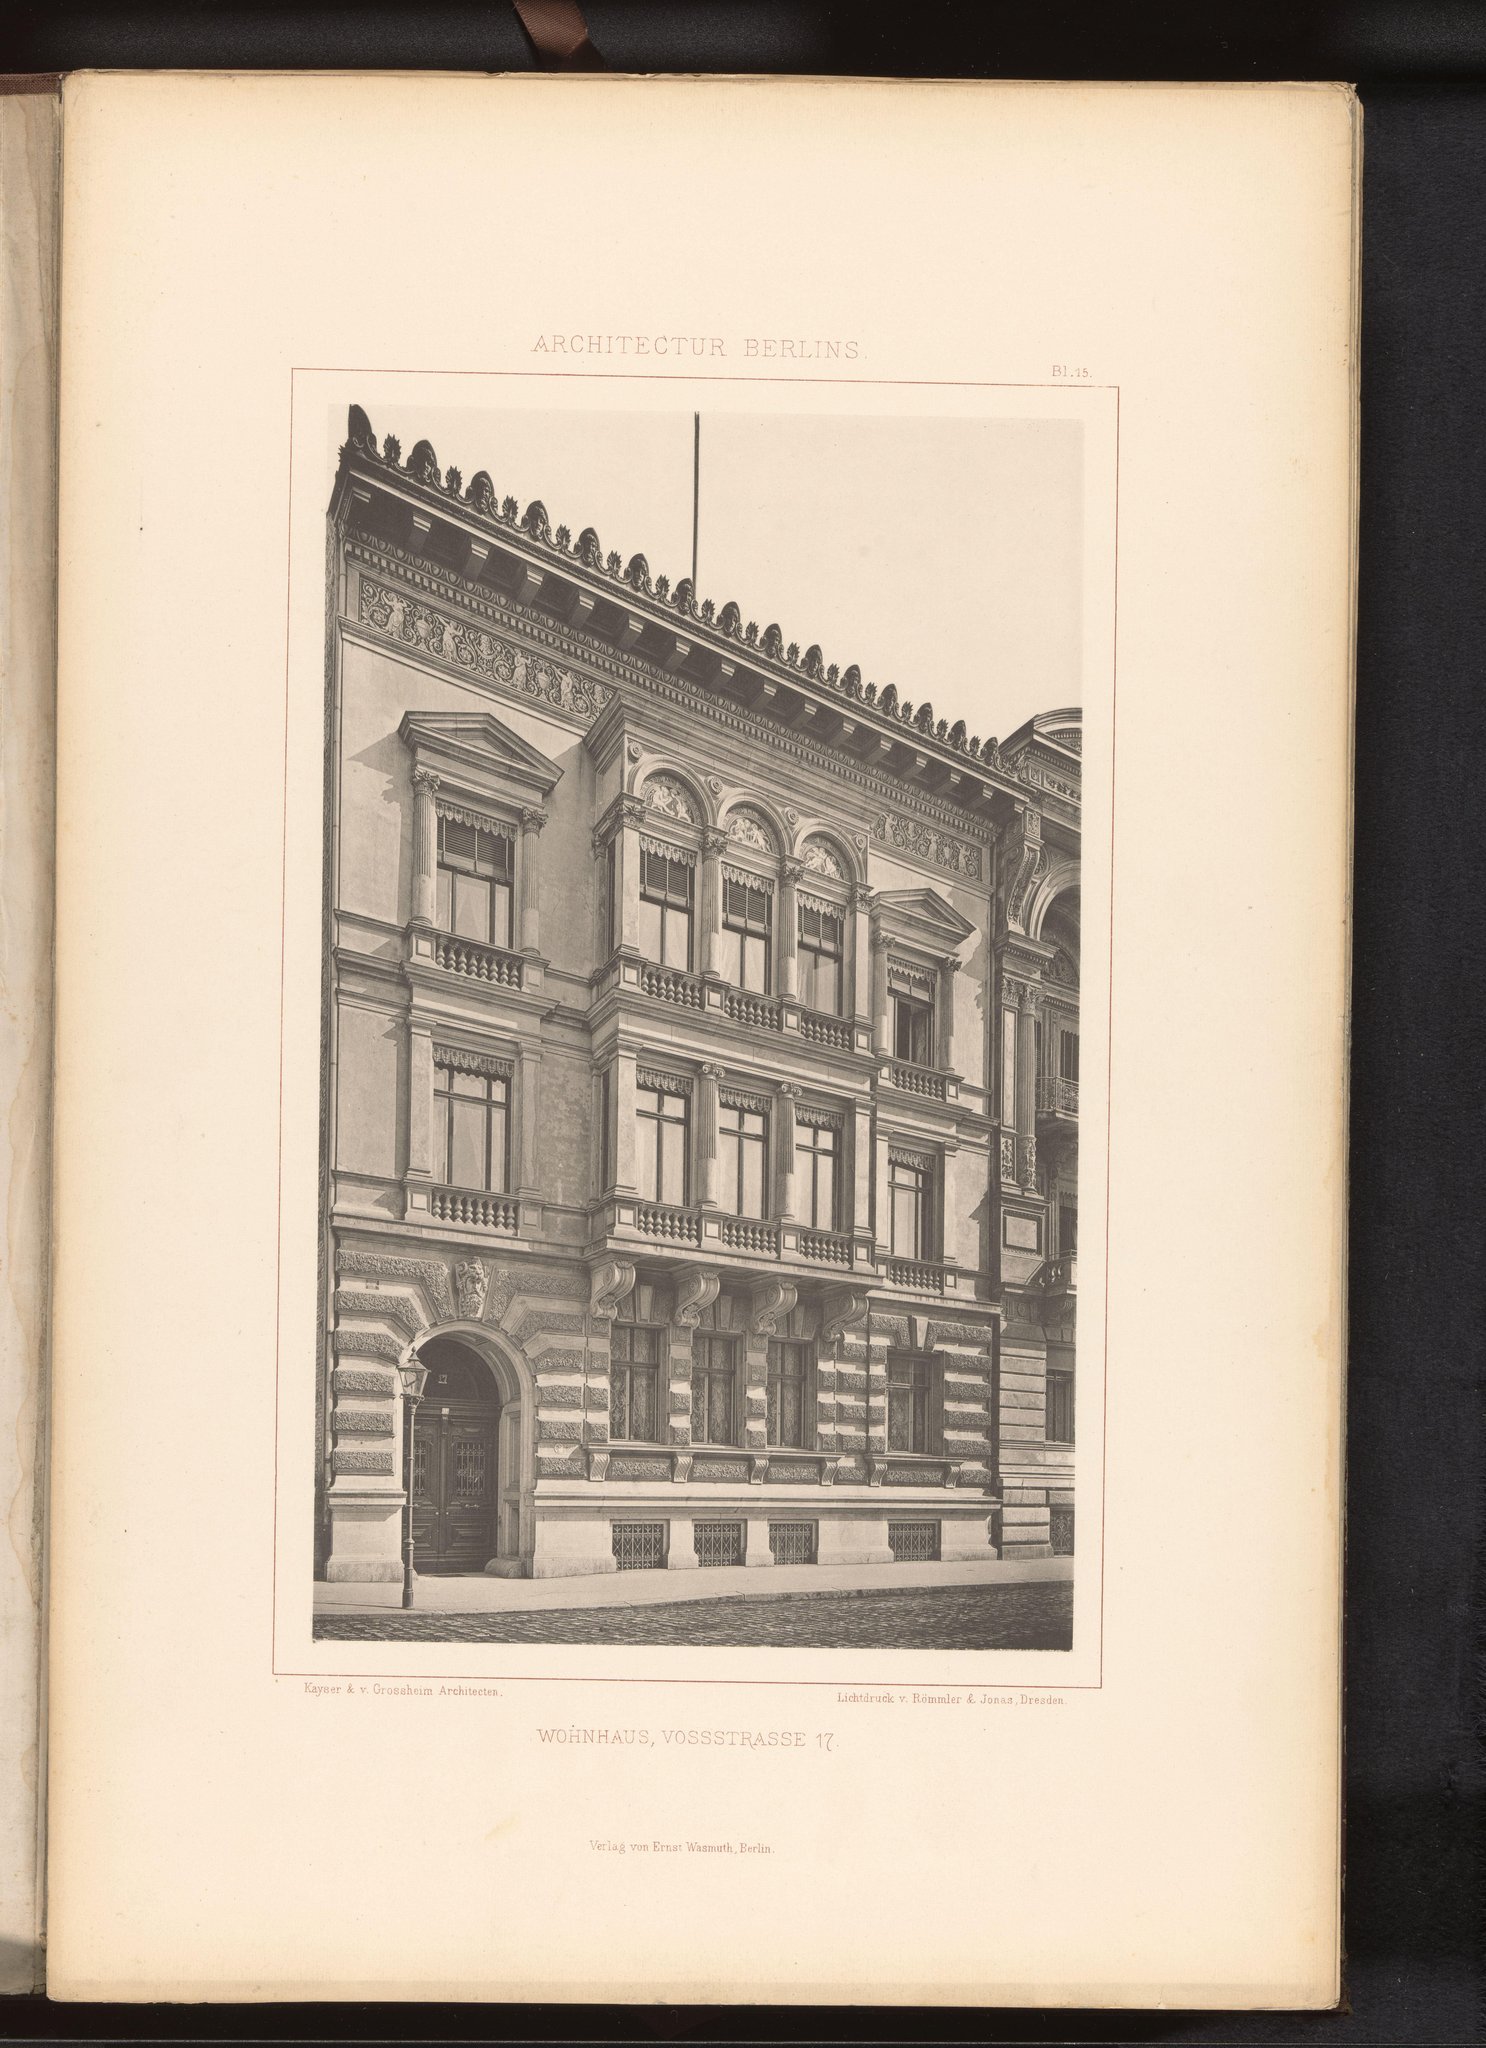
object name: photomechanical print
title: Architectur Berlins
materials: paper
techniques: photograph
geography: berlin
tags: urban housing, berlin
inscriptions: number: ‘Bl. 15.’, inscription: ‘Kayser & v. Grossheim Architecten.’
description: Deze prent maakt deel uit van een omslag met honderd prenten en zes tekstbladen.